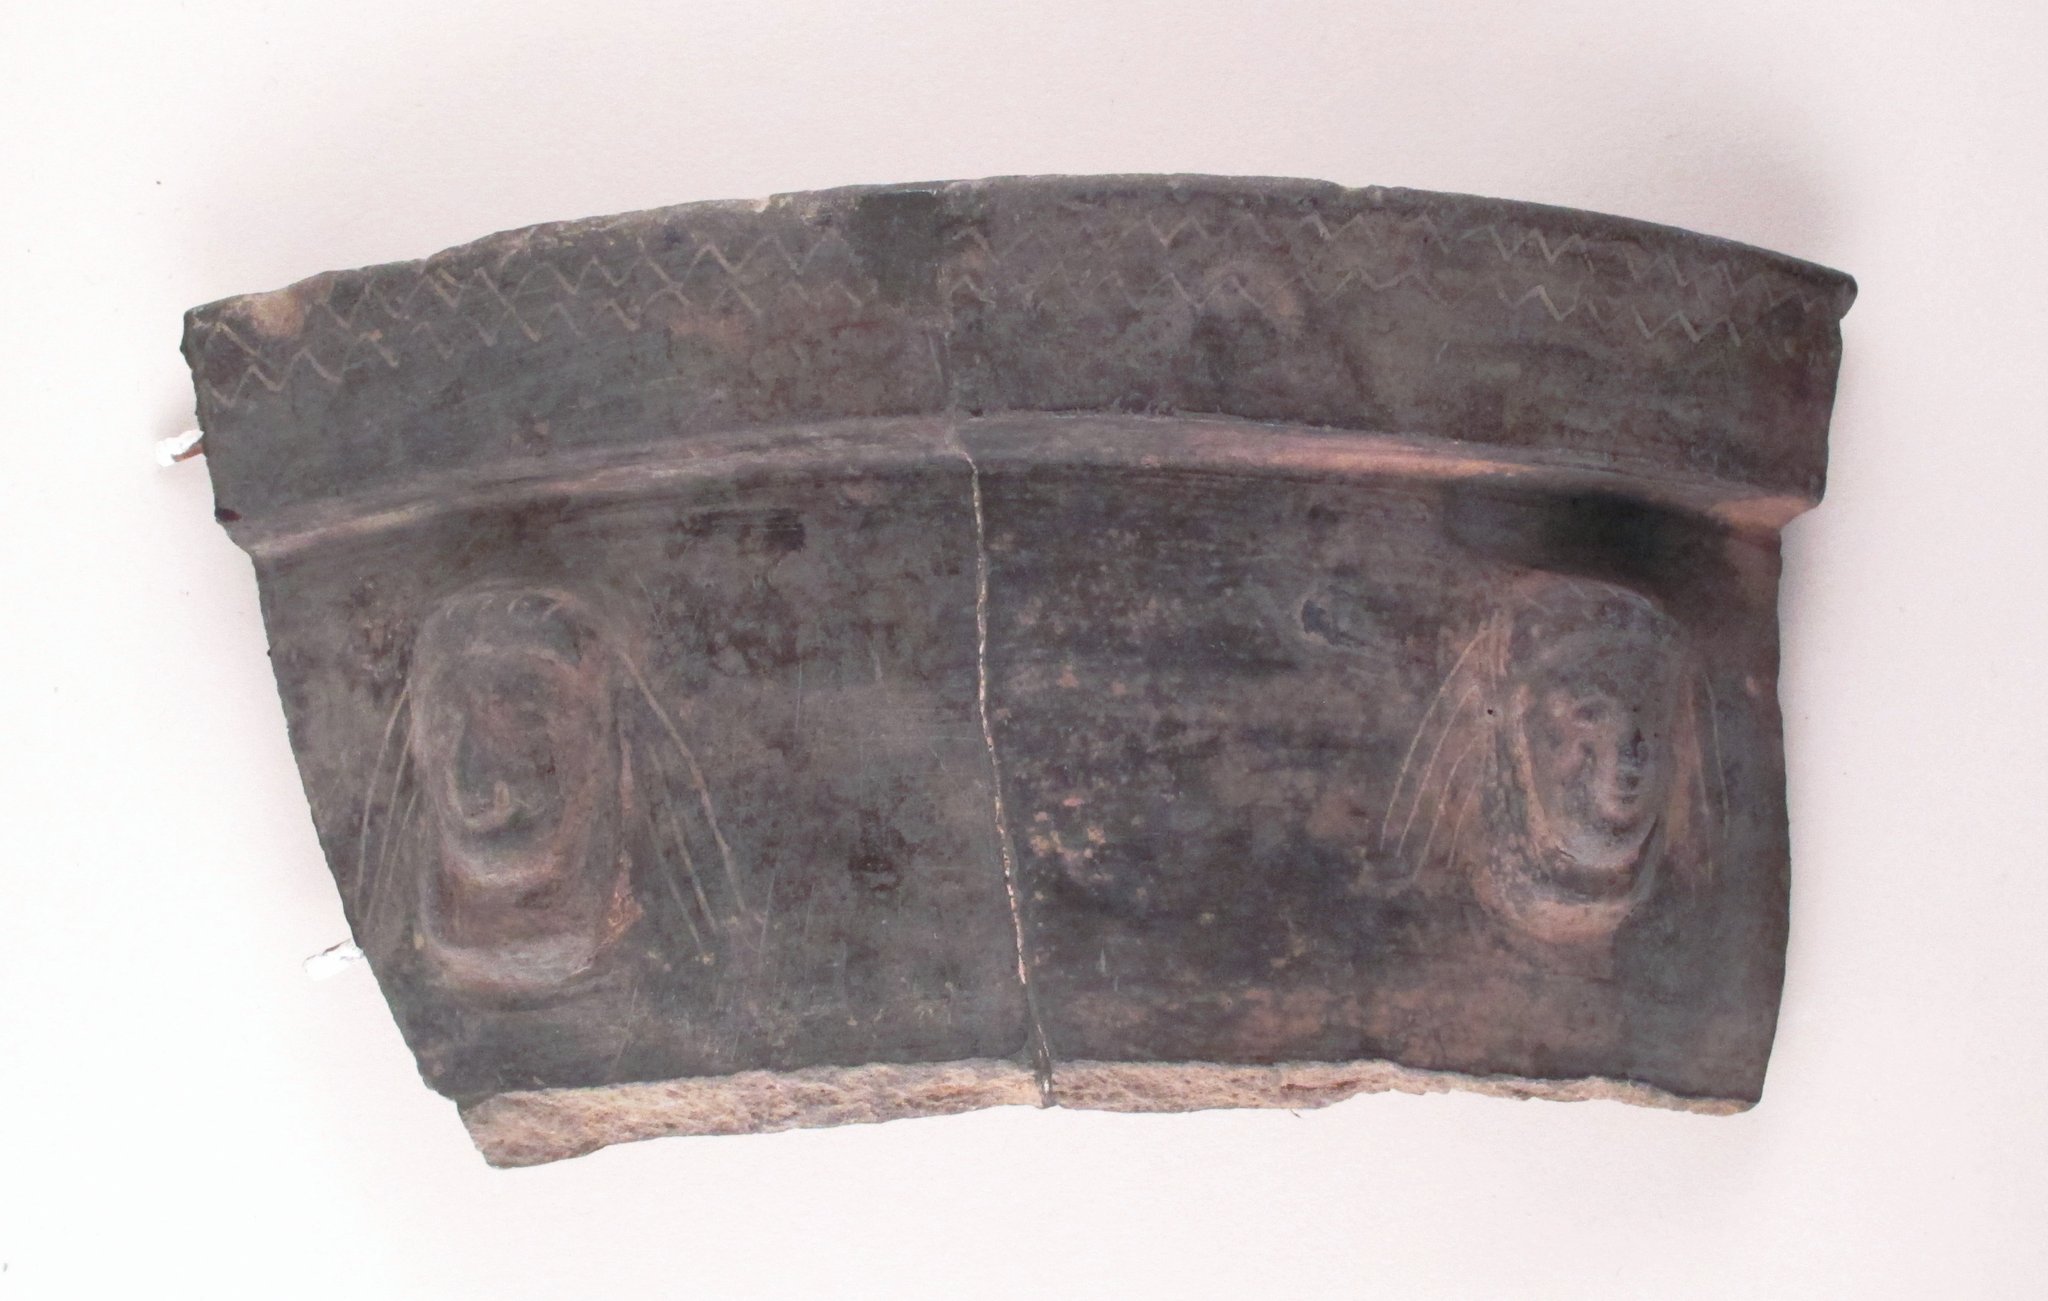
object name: vase fragment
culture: etruscan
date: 560-500 BCE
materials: terracotta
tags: heads